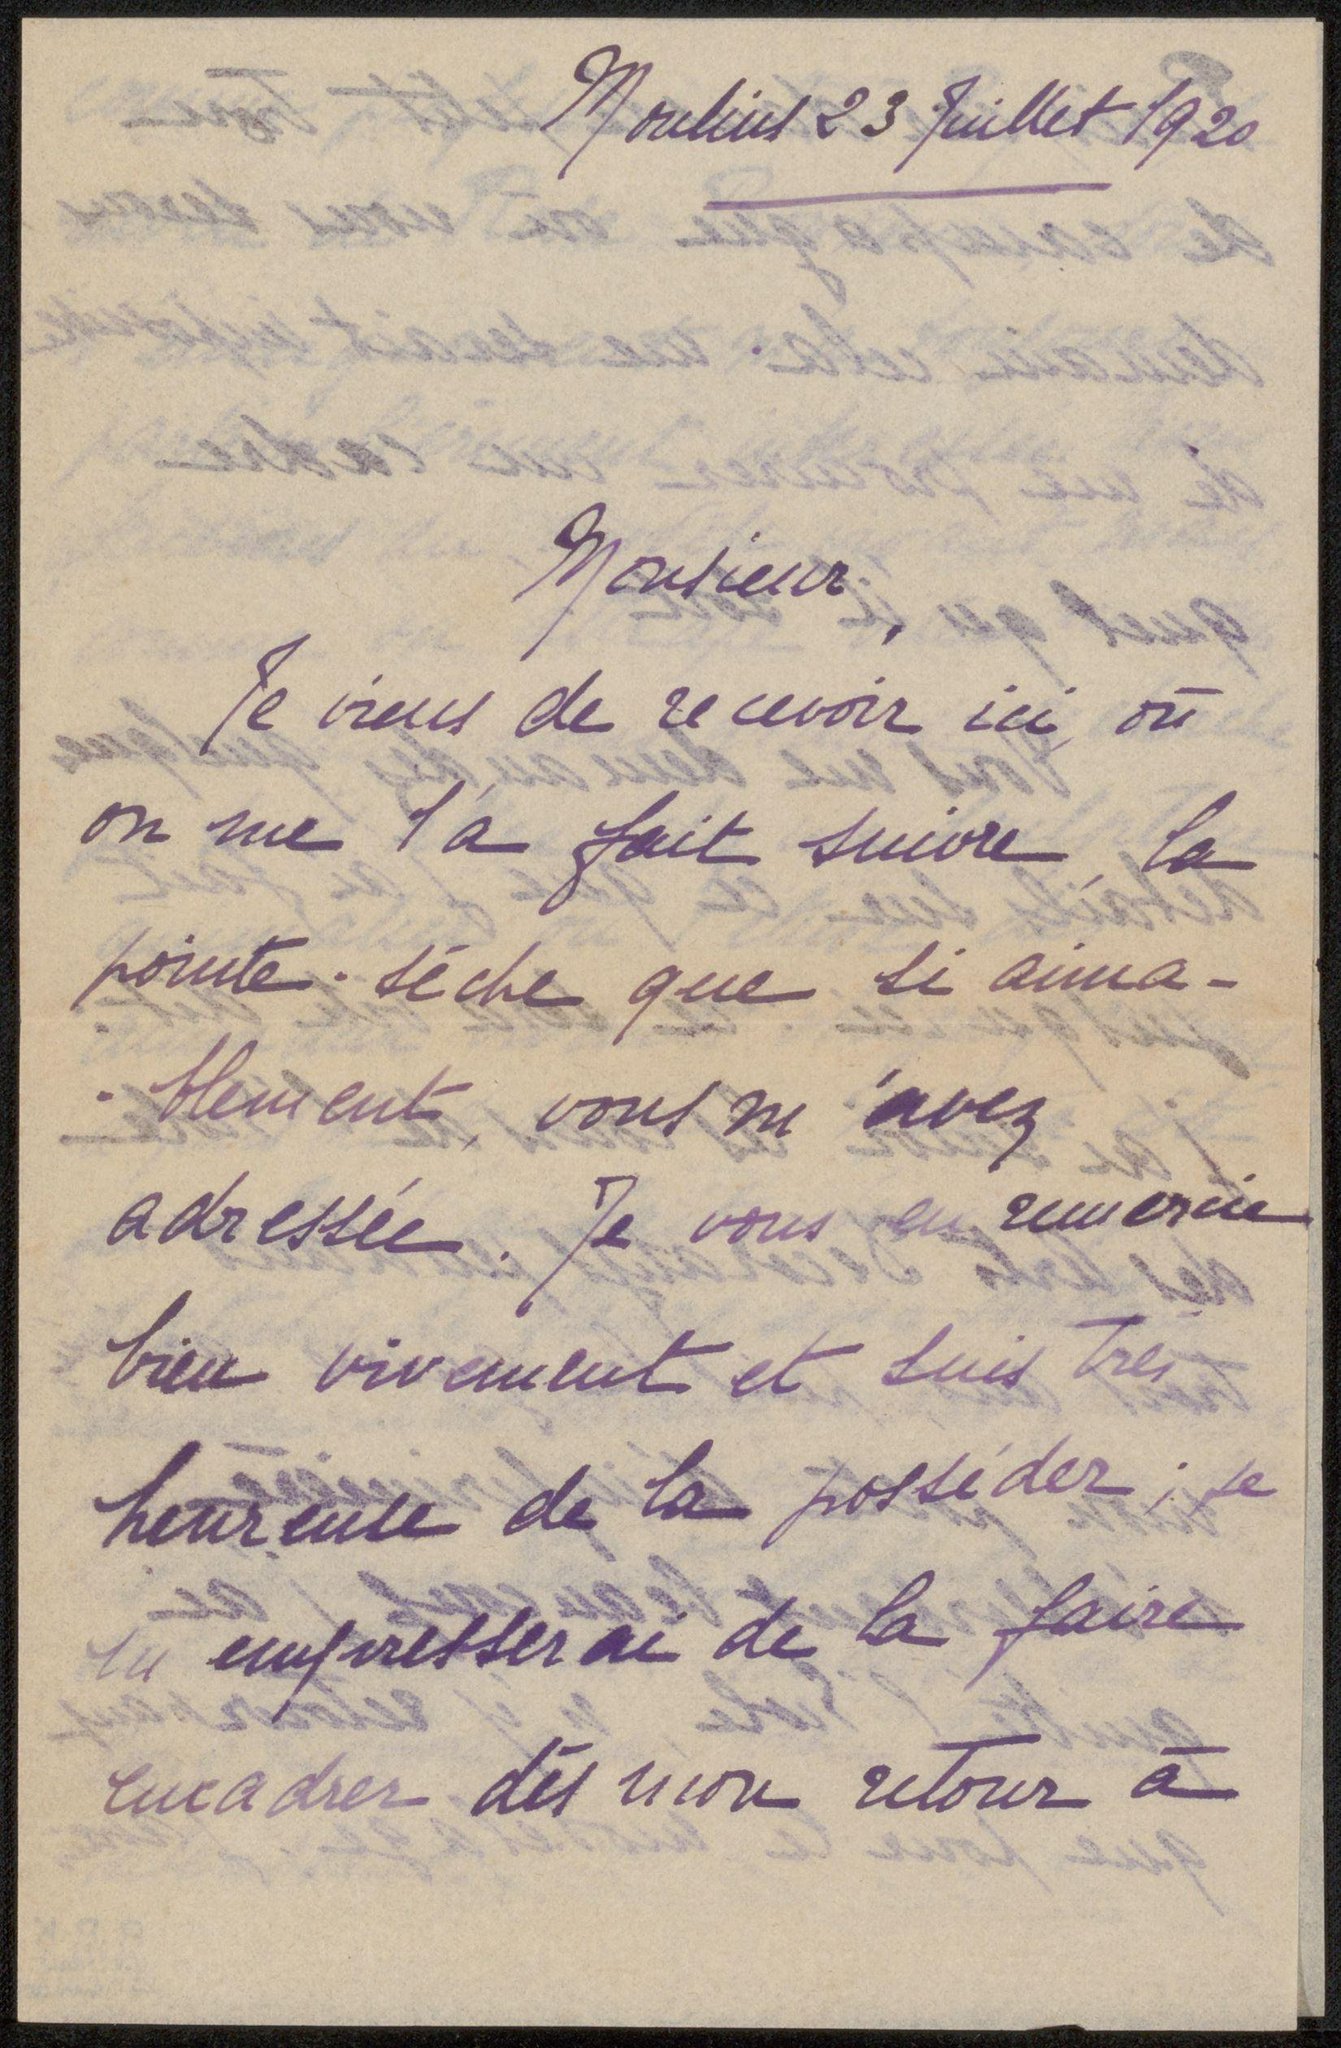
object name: letter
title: Brief aan Philip Zilcken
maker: mariette richard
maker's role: painter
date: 1920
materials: ink, paper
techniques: pen, writing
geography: moulins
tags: henri floury, the hague, painter, draughtsman, philip zilcken, artist's model, sitter, the graphic arts, sculpture, education, tuition of the artist (in general), exhibition ~ art, paris, marseille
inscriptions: collector's mark: ‘RPK’